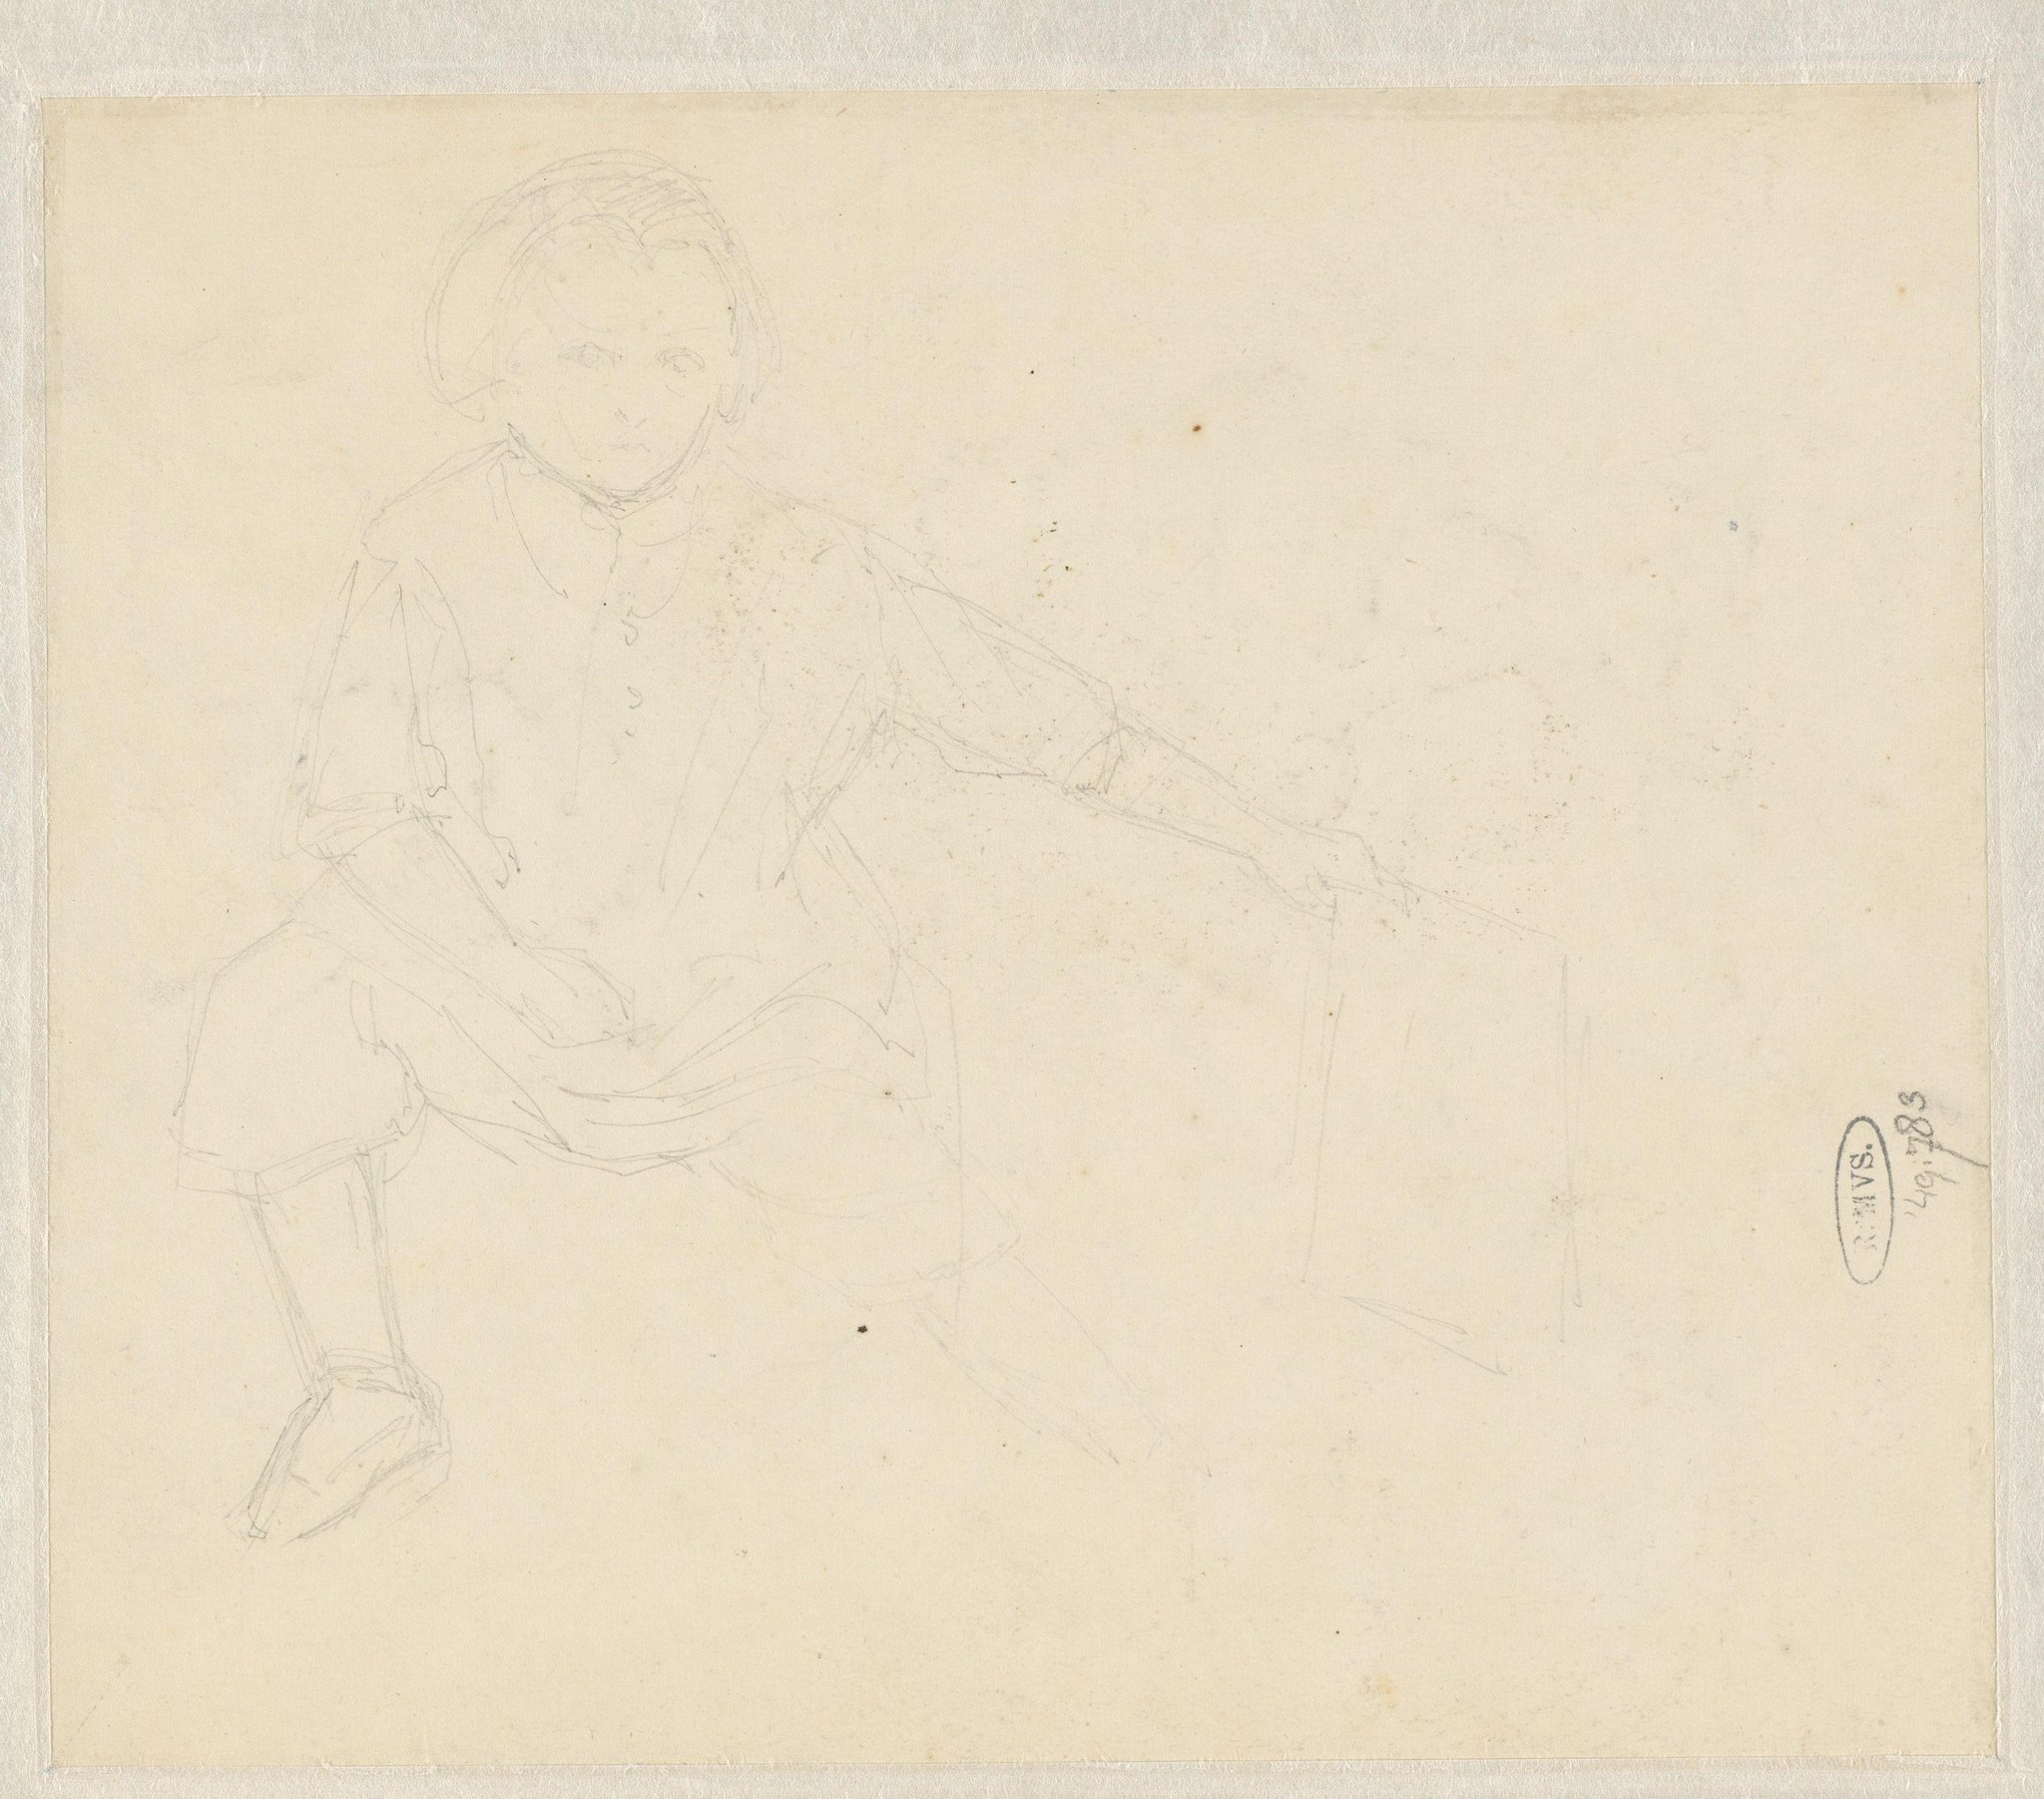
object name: drawing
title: Schets voor studie naar Gerard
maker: august allebé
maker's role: draughtsman, print maker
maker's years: 1838-1927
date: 1852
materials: paper, pencil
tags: gerard allebé, historical persons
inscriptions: date: ‘1852’